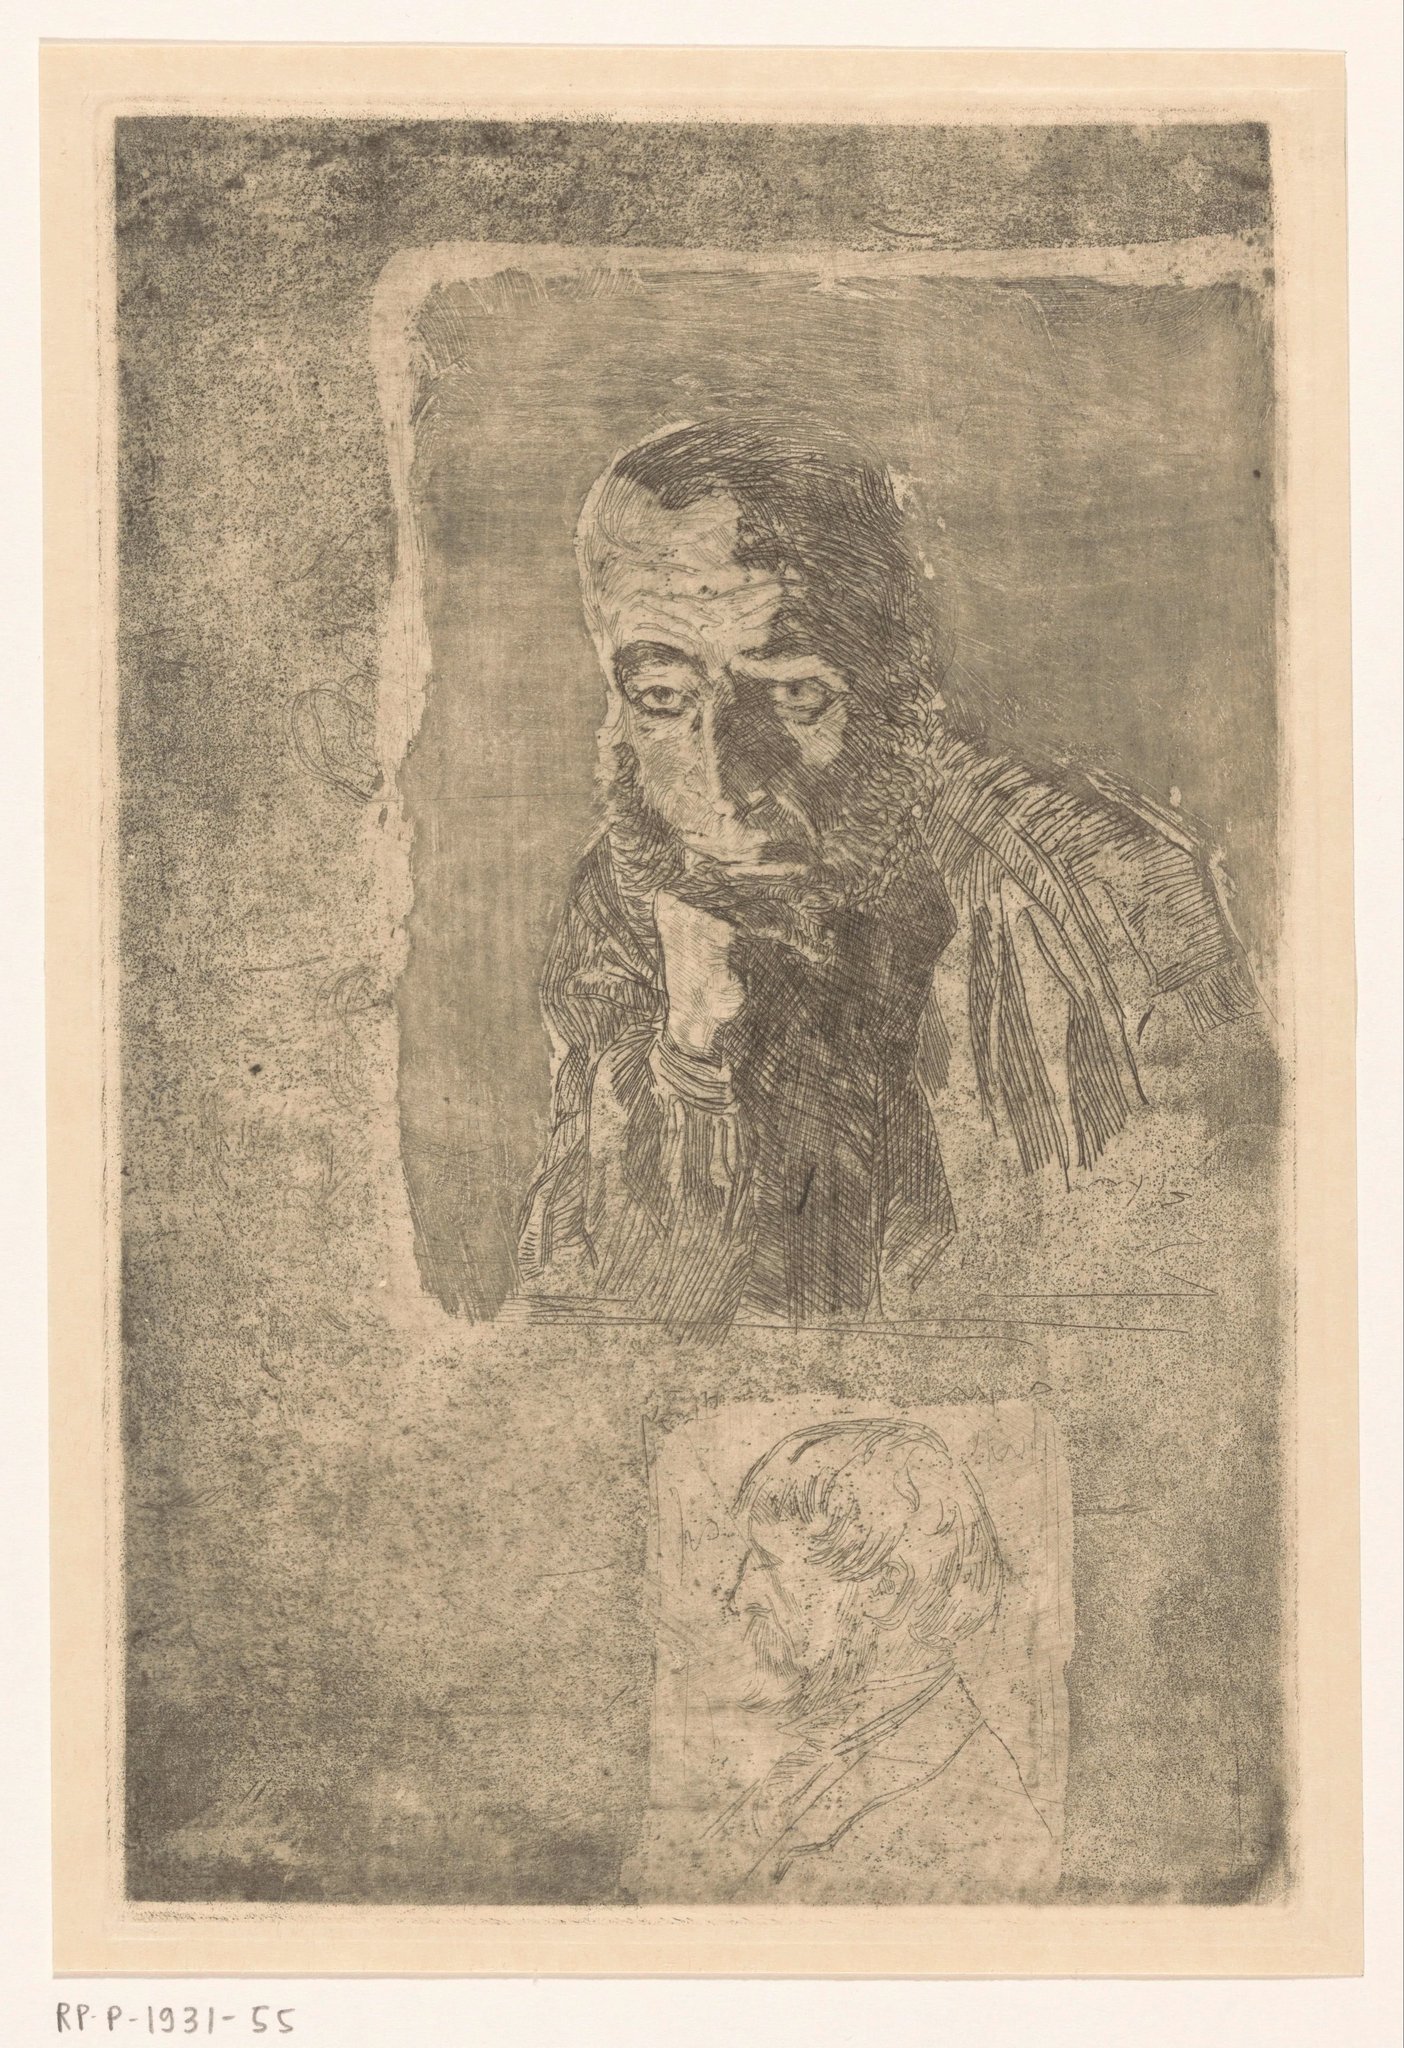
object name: print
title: Twee bebaarde mannen, van wie er één zijn hoofd met zijn hand ondersteunt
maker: martinus van regteren altena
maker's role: painter, print maker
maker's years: 1866-1908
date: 1876-1908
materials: paper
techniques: etching, intaglio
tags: anonymous historical person portrayed, head held in the hand(s), with elbows leaning on an elevation or on the knees, beard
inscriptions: collector's mark: Lugt 2228